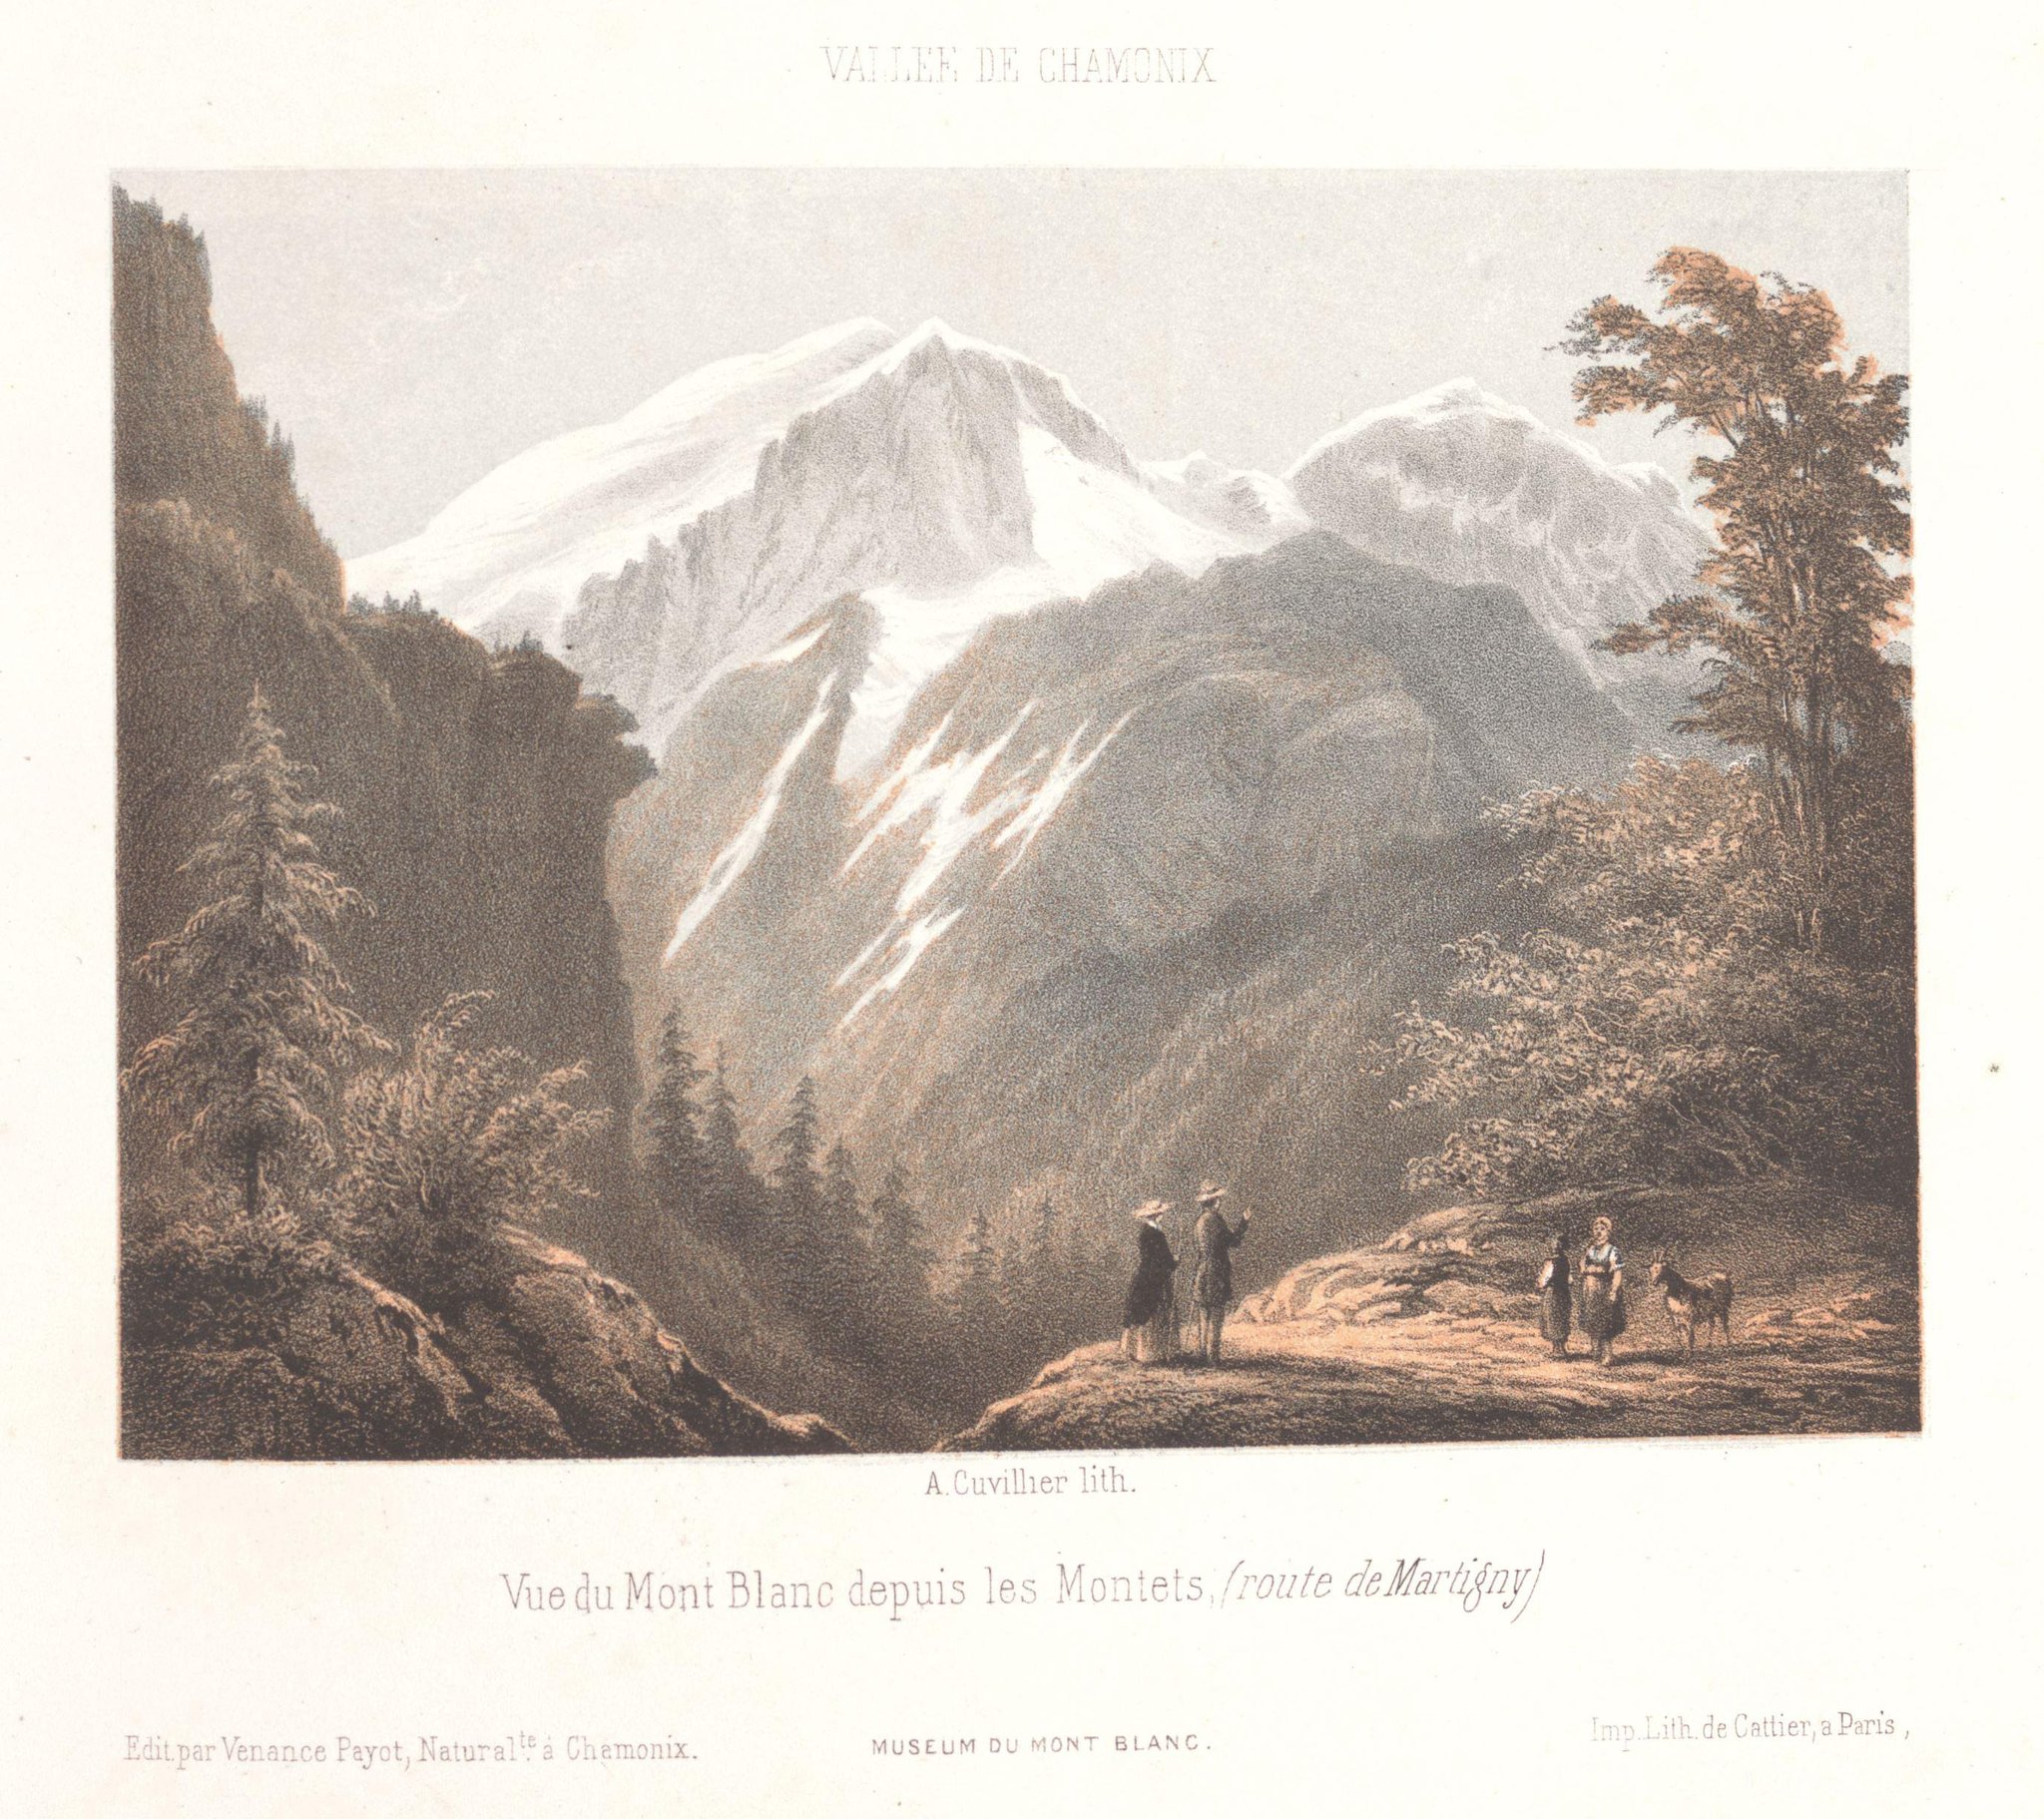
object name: print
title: Zicht op de gletsjer Mer-de-Glace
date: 1858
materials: paper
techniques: lithograph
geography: chamonix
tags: glacier (+ landscape with figures, staffage)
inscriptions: collector's mark: Lugt 2228a